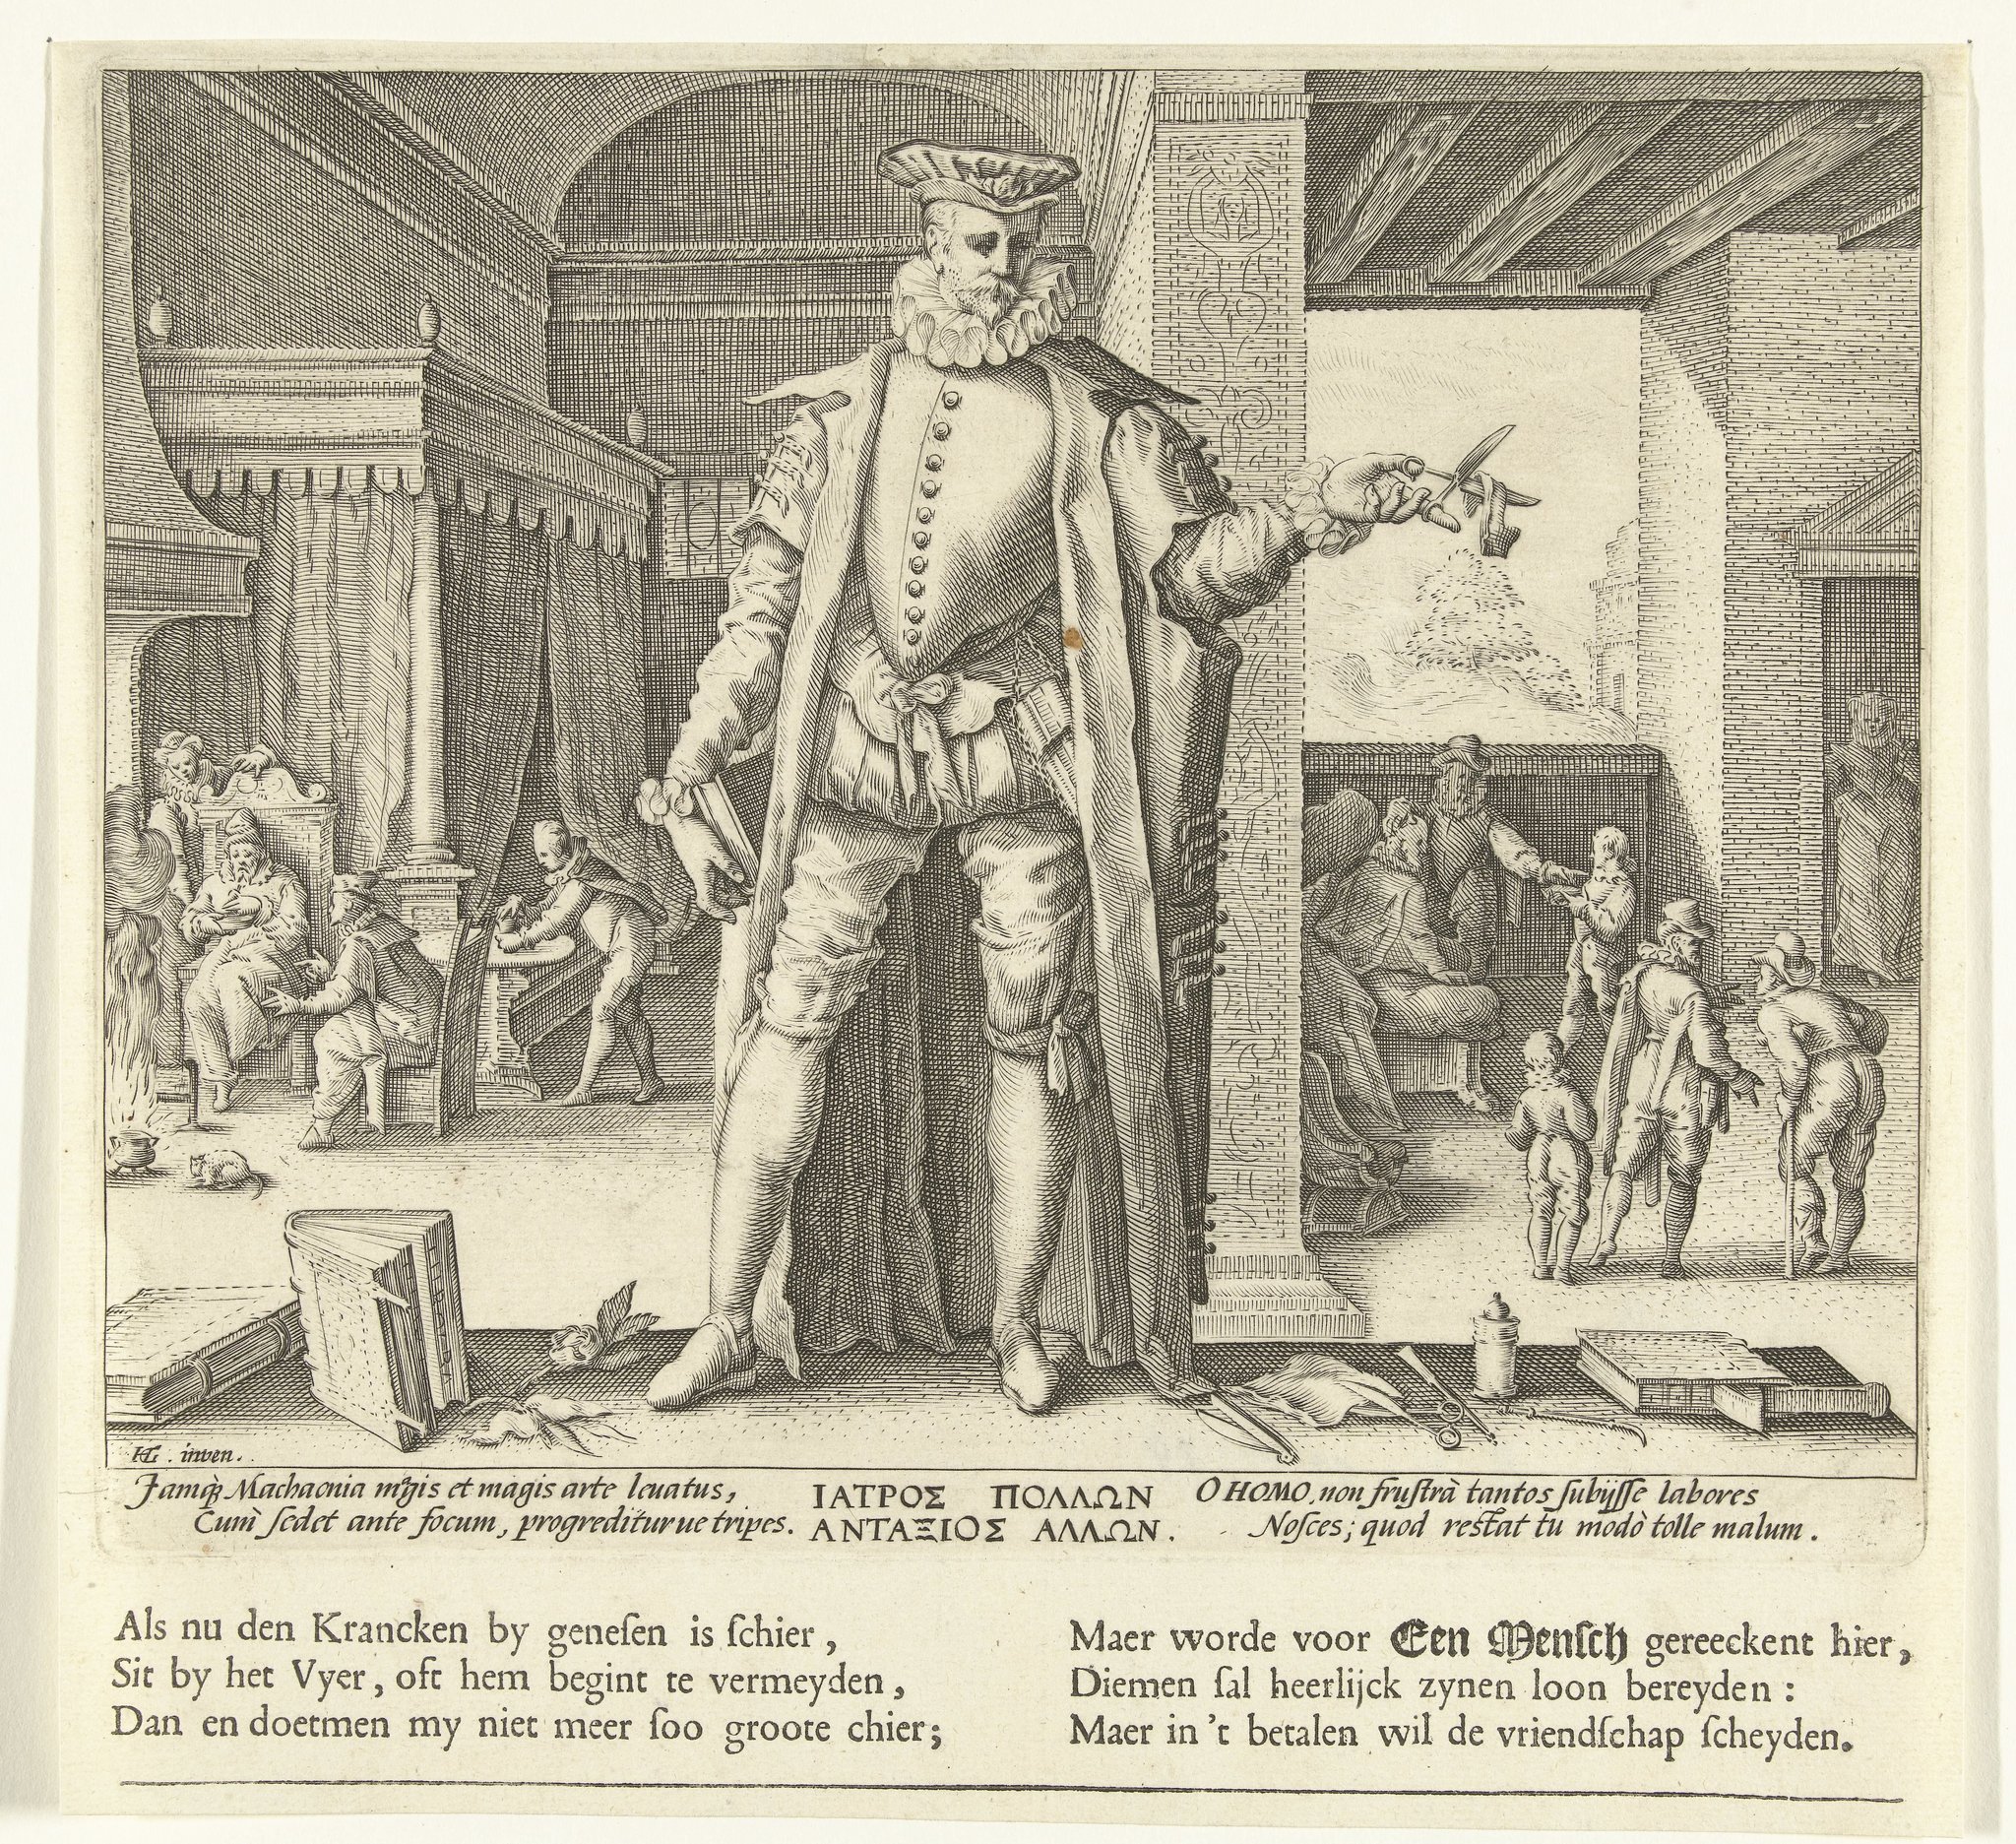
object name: print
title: De arts als mens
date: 1587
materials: paper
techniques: engraving, letterpress printing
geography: haarlem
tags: crutches, bed with tester, warming oneself at a fire (or hearth, stove, fire-pan, brazier), physician, doctor, healing of sick person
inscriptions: collector's mark: Lugt 2228a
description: In een huis zit een man bij de haard naast zijn bed, familieleden zorgend om hem heen. Een arts zit pratend naast hem. In het vertrek daar rechts naast is te zien wat er gebeurd is met de man sinds zijn val (zie de eerste twee prenten van de serie): zijn hoofdwond is verzorgd en hij heeft op krukken gelopen. Op de voorgrond nogmaals de arts, staand te midden van boeken en medische instrumenten. Onder de voorstelling gegraveerde Latijnse en Griekse teksten en (buiten de plaatrand maar op hetzelfde blad) een gedrukte Nederlandse tekst, waarin wordt uitgelegd dat de arts als een gewoon mens wordt behandeld als de zieke bijna genezen is. Deze prent is onderdeel van een serie van vier prenten waarop verbeeld is hoe de arts beschouwd en gewaardeerd wordt tijdens zijn bezoek aan een zieke: bij binnenkomst als een god, na de eerste hulp als een engel, bij genezing als een mens en wanneer er betaald moet worden als een duivel.